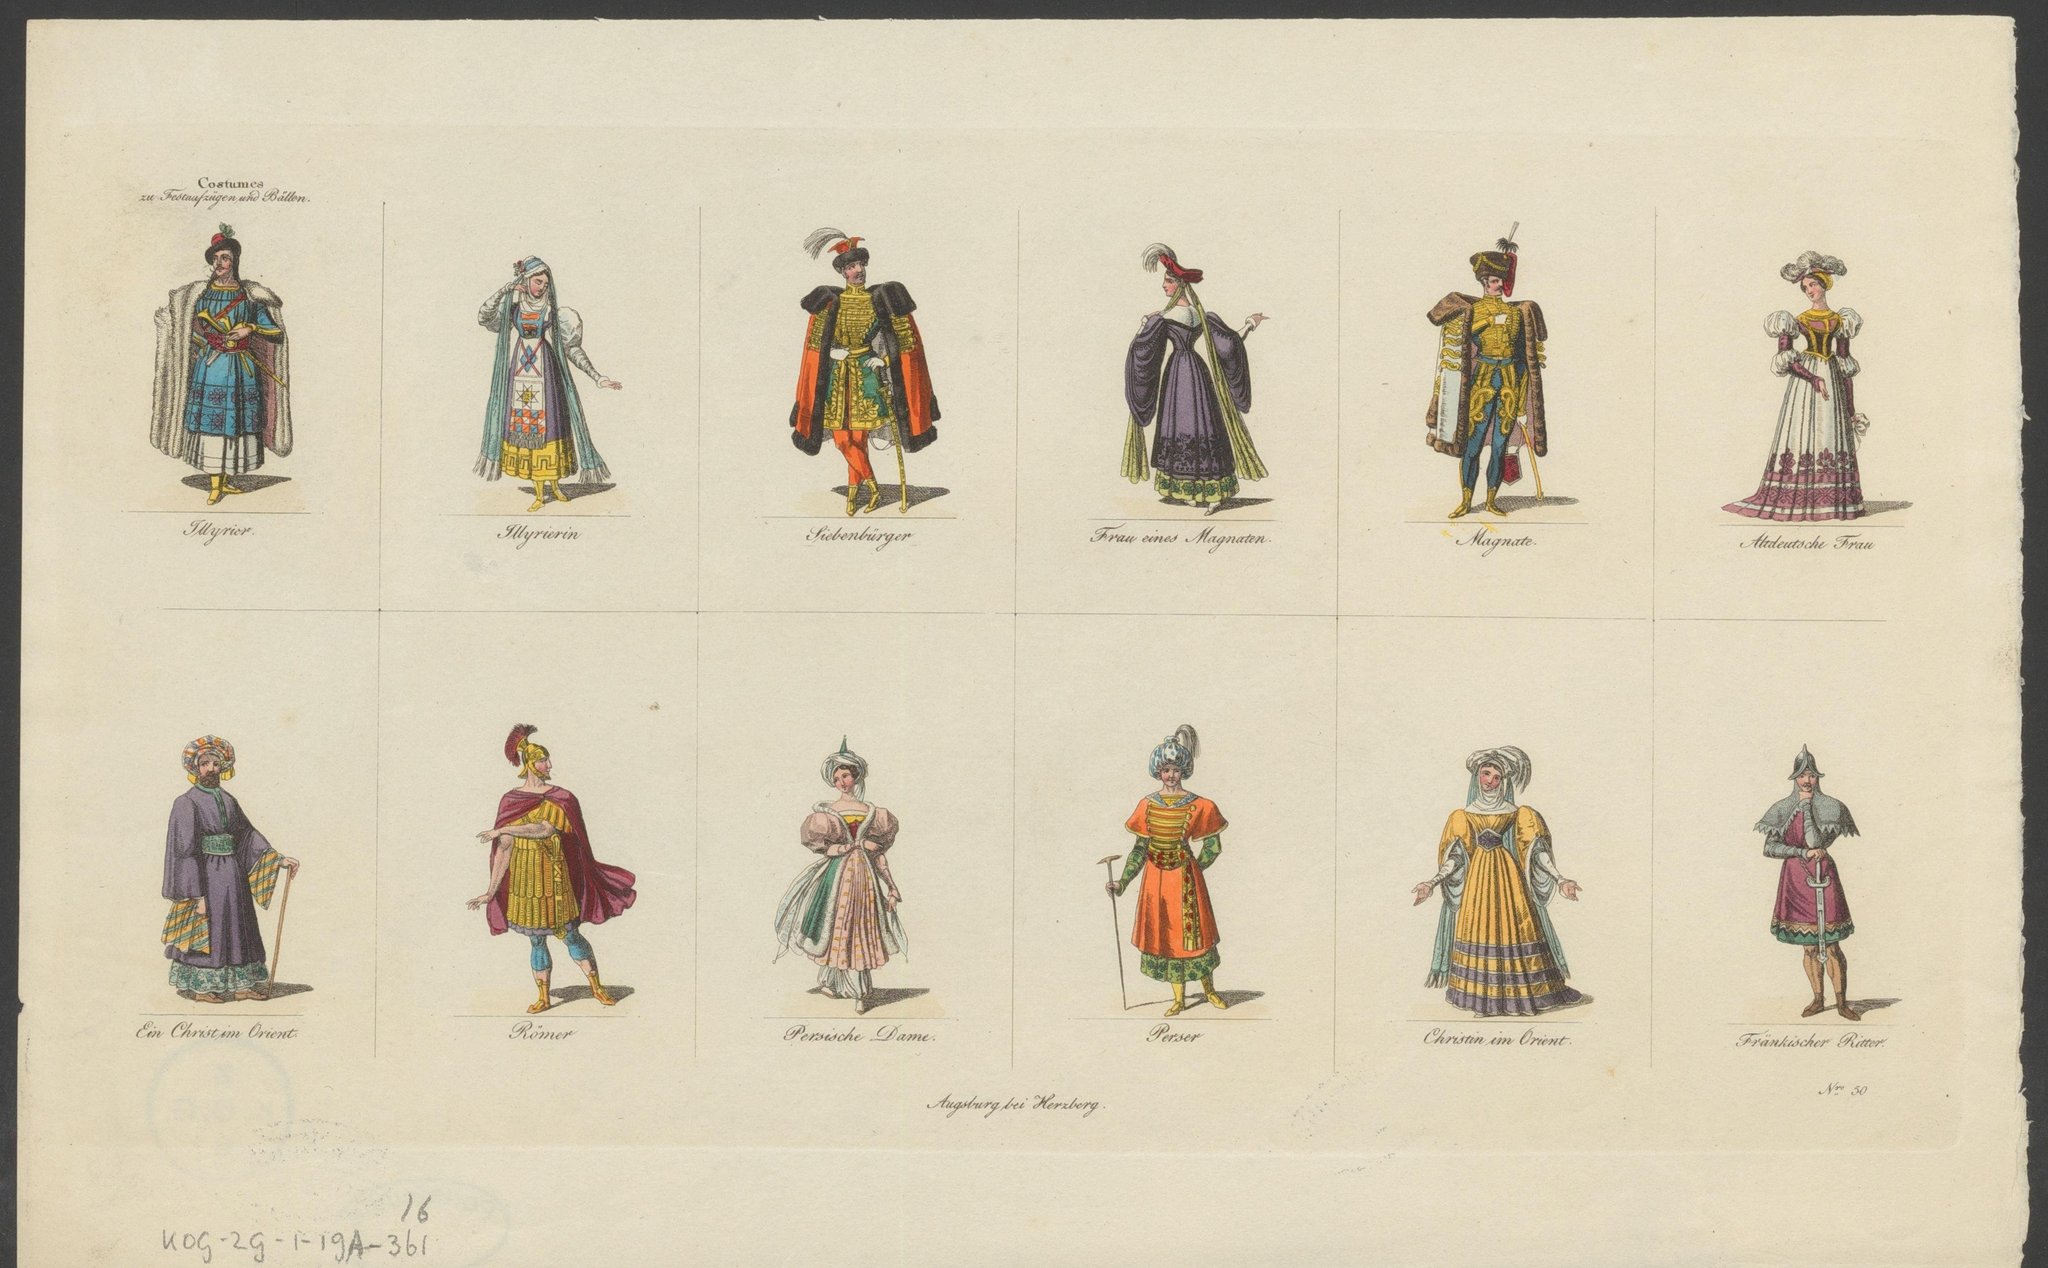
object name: print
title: Kostuums van verschillende volken voor processies en festiviteiten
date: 1801-1850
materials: paper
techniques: engraving, etching, hand coloring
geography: augsburg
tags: folk costume, regional costume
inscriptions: collector's mark: Lugt 1641, stamp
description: Twee rijen met elk zes voorstellingen van kostuums van verschillende volken voor processies en festiviteiten. Onder iedere voorstelling de naam van het verbeelde volk. Rechtsonder genummerd: Nre. 50. Onderwerpsrubrieken binnen de Atlas Zeden en Gewoonten: Zeden en Gewoonten in Engeren Zin, Des menschen beging, midden en einde, Kinderleven – Kinderspel en Kinderprenten.